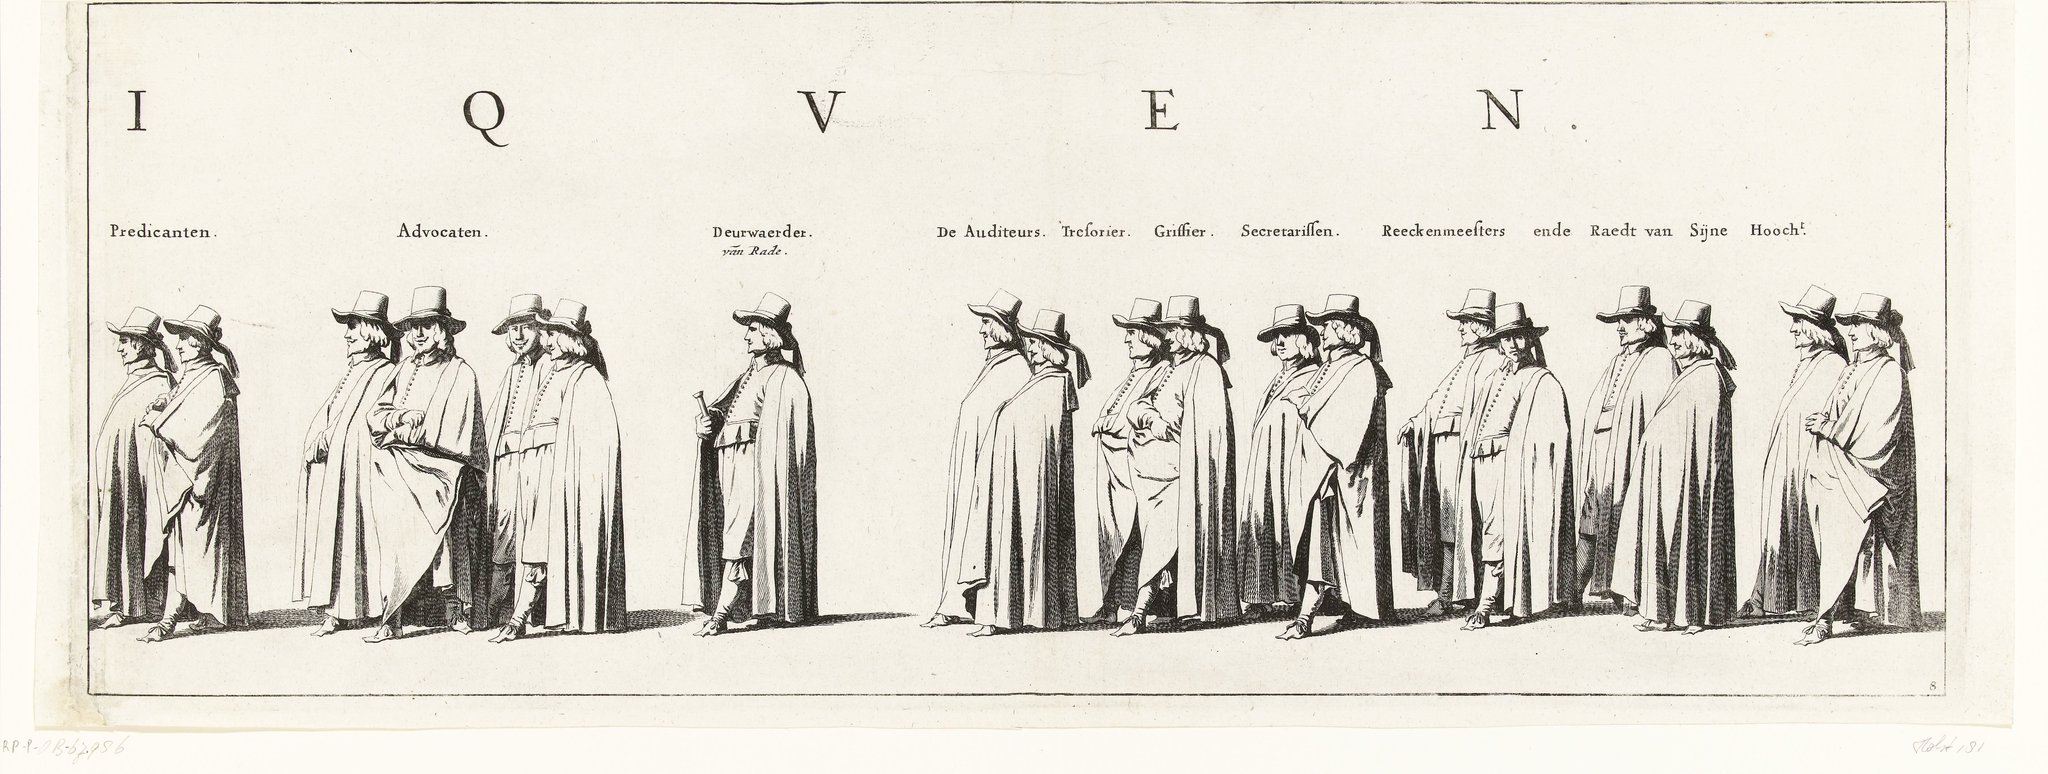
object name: print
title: Begraeffenisse van Syne Hoogheyt Frederick Henrick, by der Gratien Gods Prince van Orange, Grave van Nassau &c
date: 1647-1651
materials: paper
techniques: etching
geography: amsterdam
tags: delft, the hague, frederick henry (prince of orange), cortege, funeral procession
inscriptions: collector's mark: Lugt 2228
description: De begrafenisstoet van stadhouder Frederik Hendrik te 's-Gravenhage op 10 mei 1647. Plaat nr. 8 met een deel van de stoet, boven de personen staat hun functie. Onderdeel van een serie van 30 platen en 20 tekstbladen, bedoeld om aan elkaar geplakt te worden.